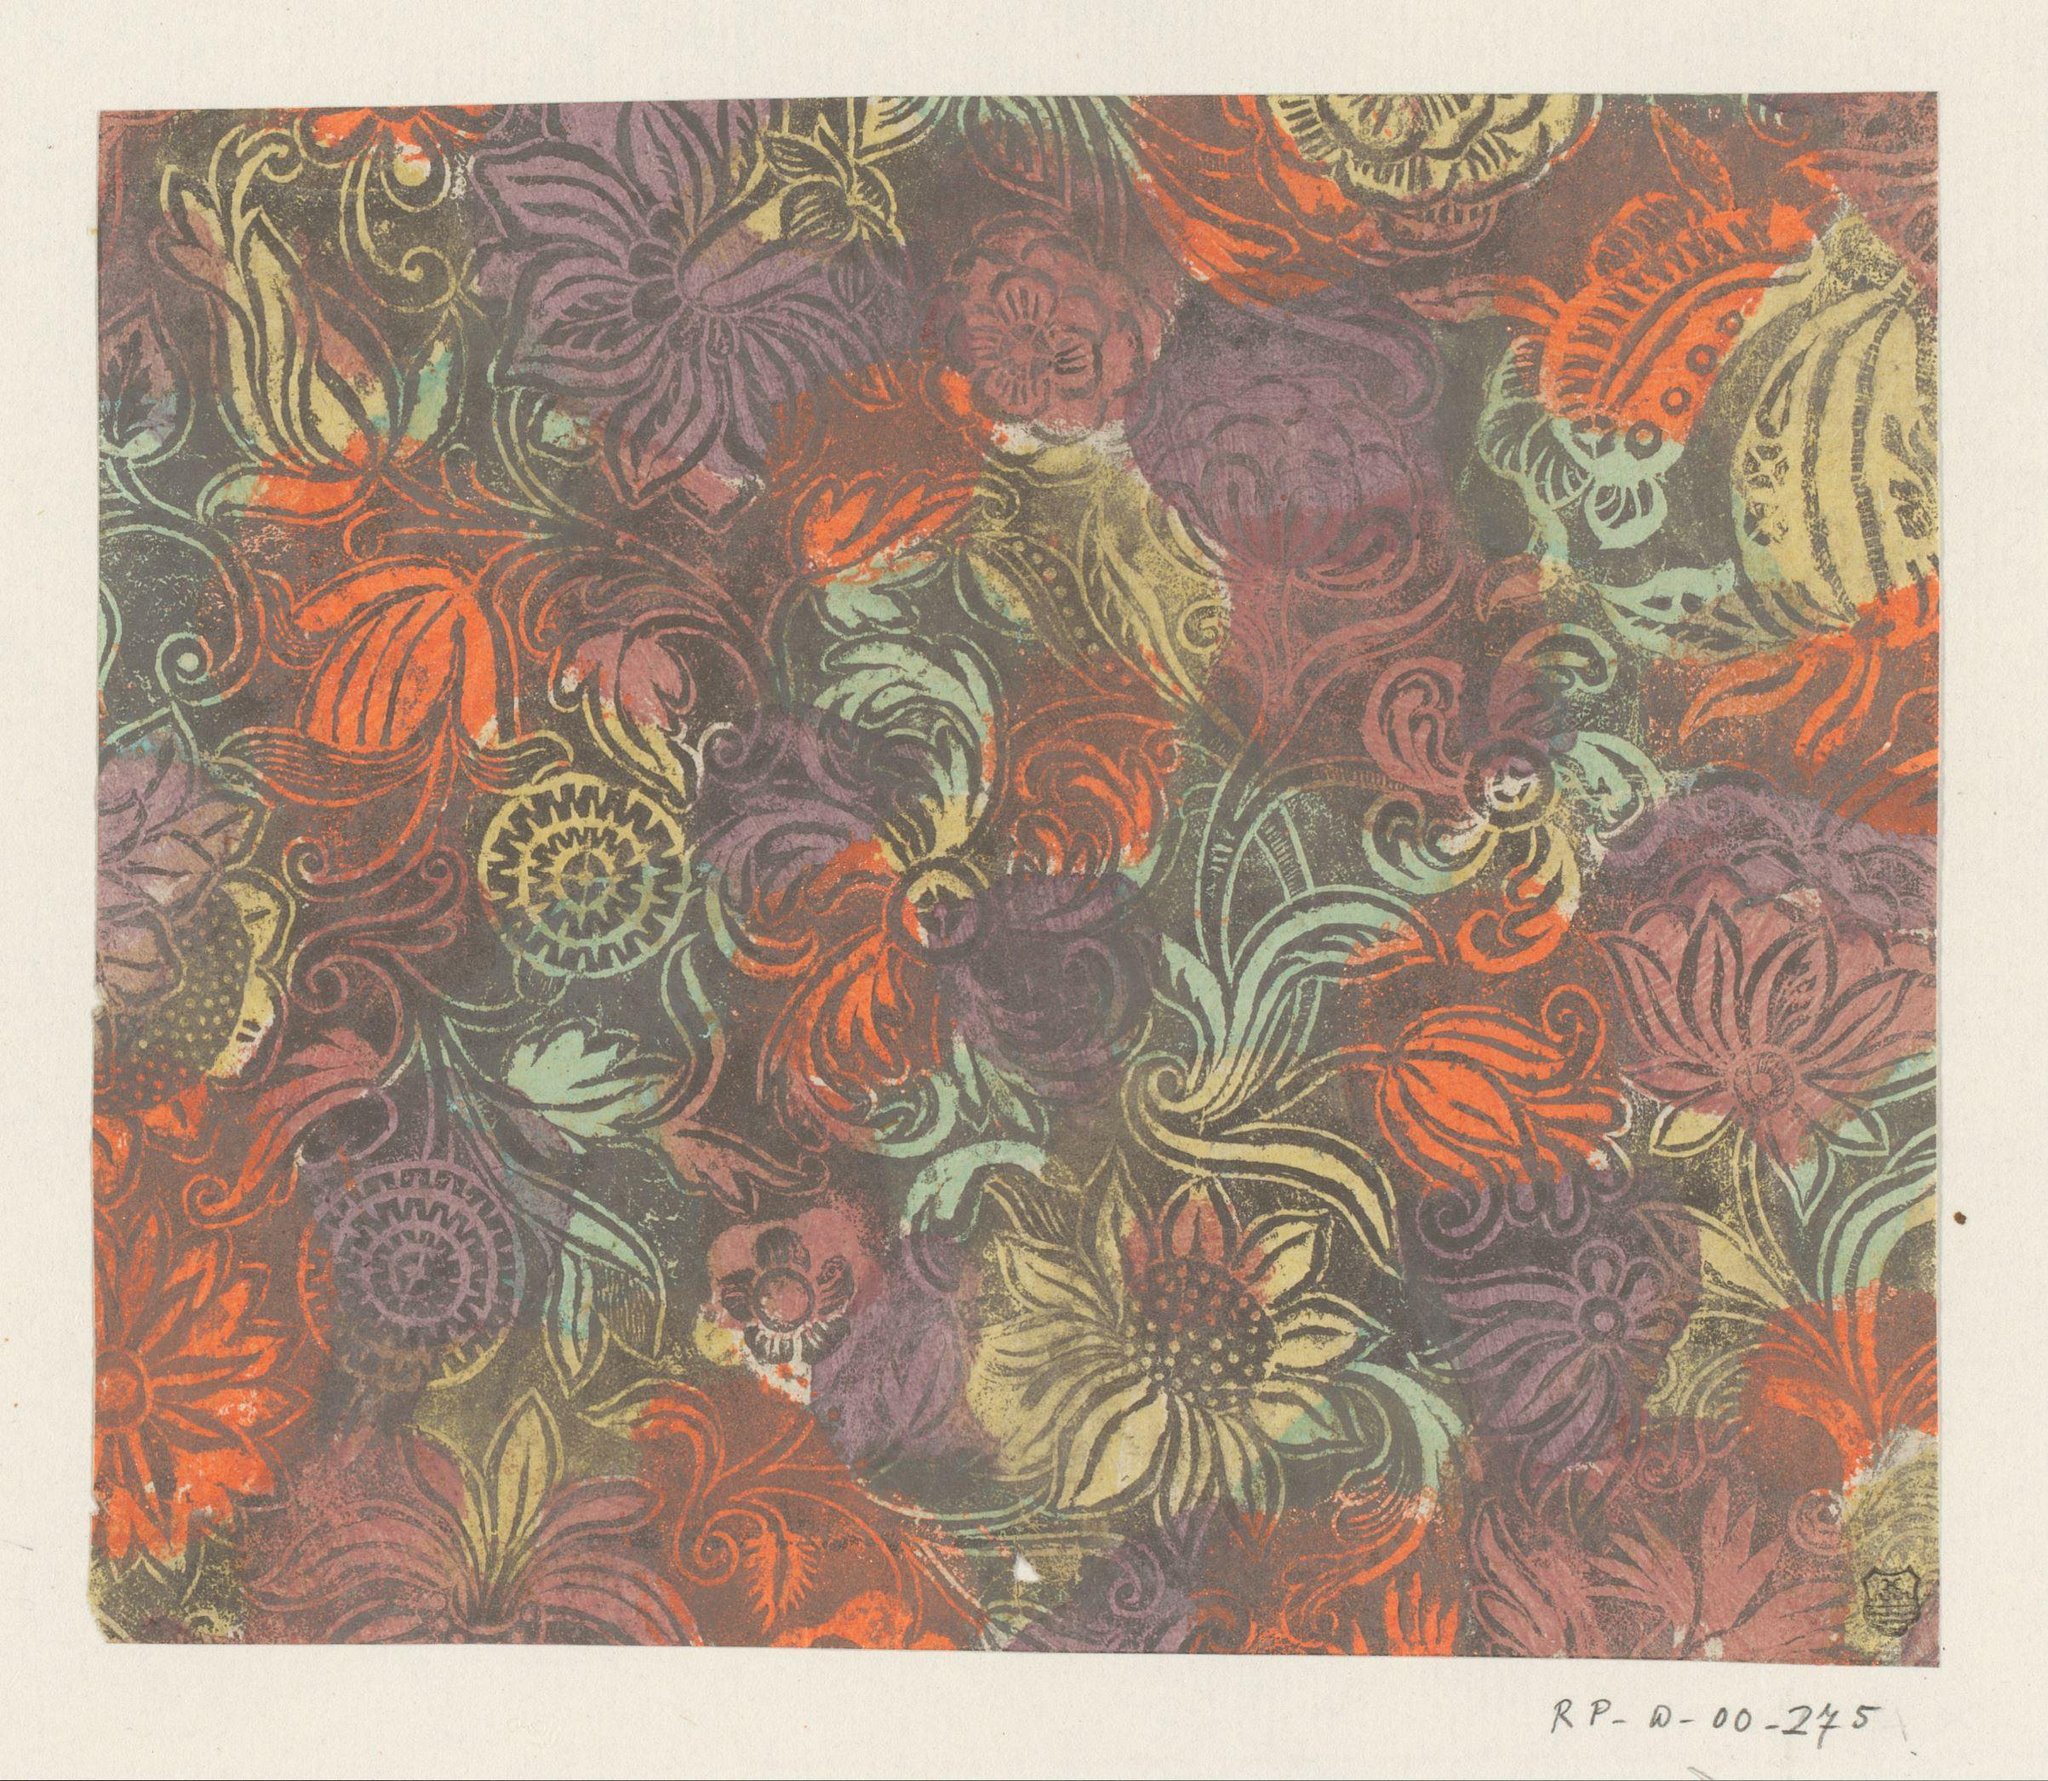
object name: brocade paper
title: Blad met ornament van bloemen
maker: Anonymous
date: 1700-1800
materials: gold leaf, paint, paper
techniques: relief print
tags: ornament derived from plant forms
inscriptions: collector's mark: Lugt 2760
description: Blad met ornament van bloemen en gekartelde cirkels, links twee ronde bloemen.